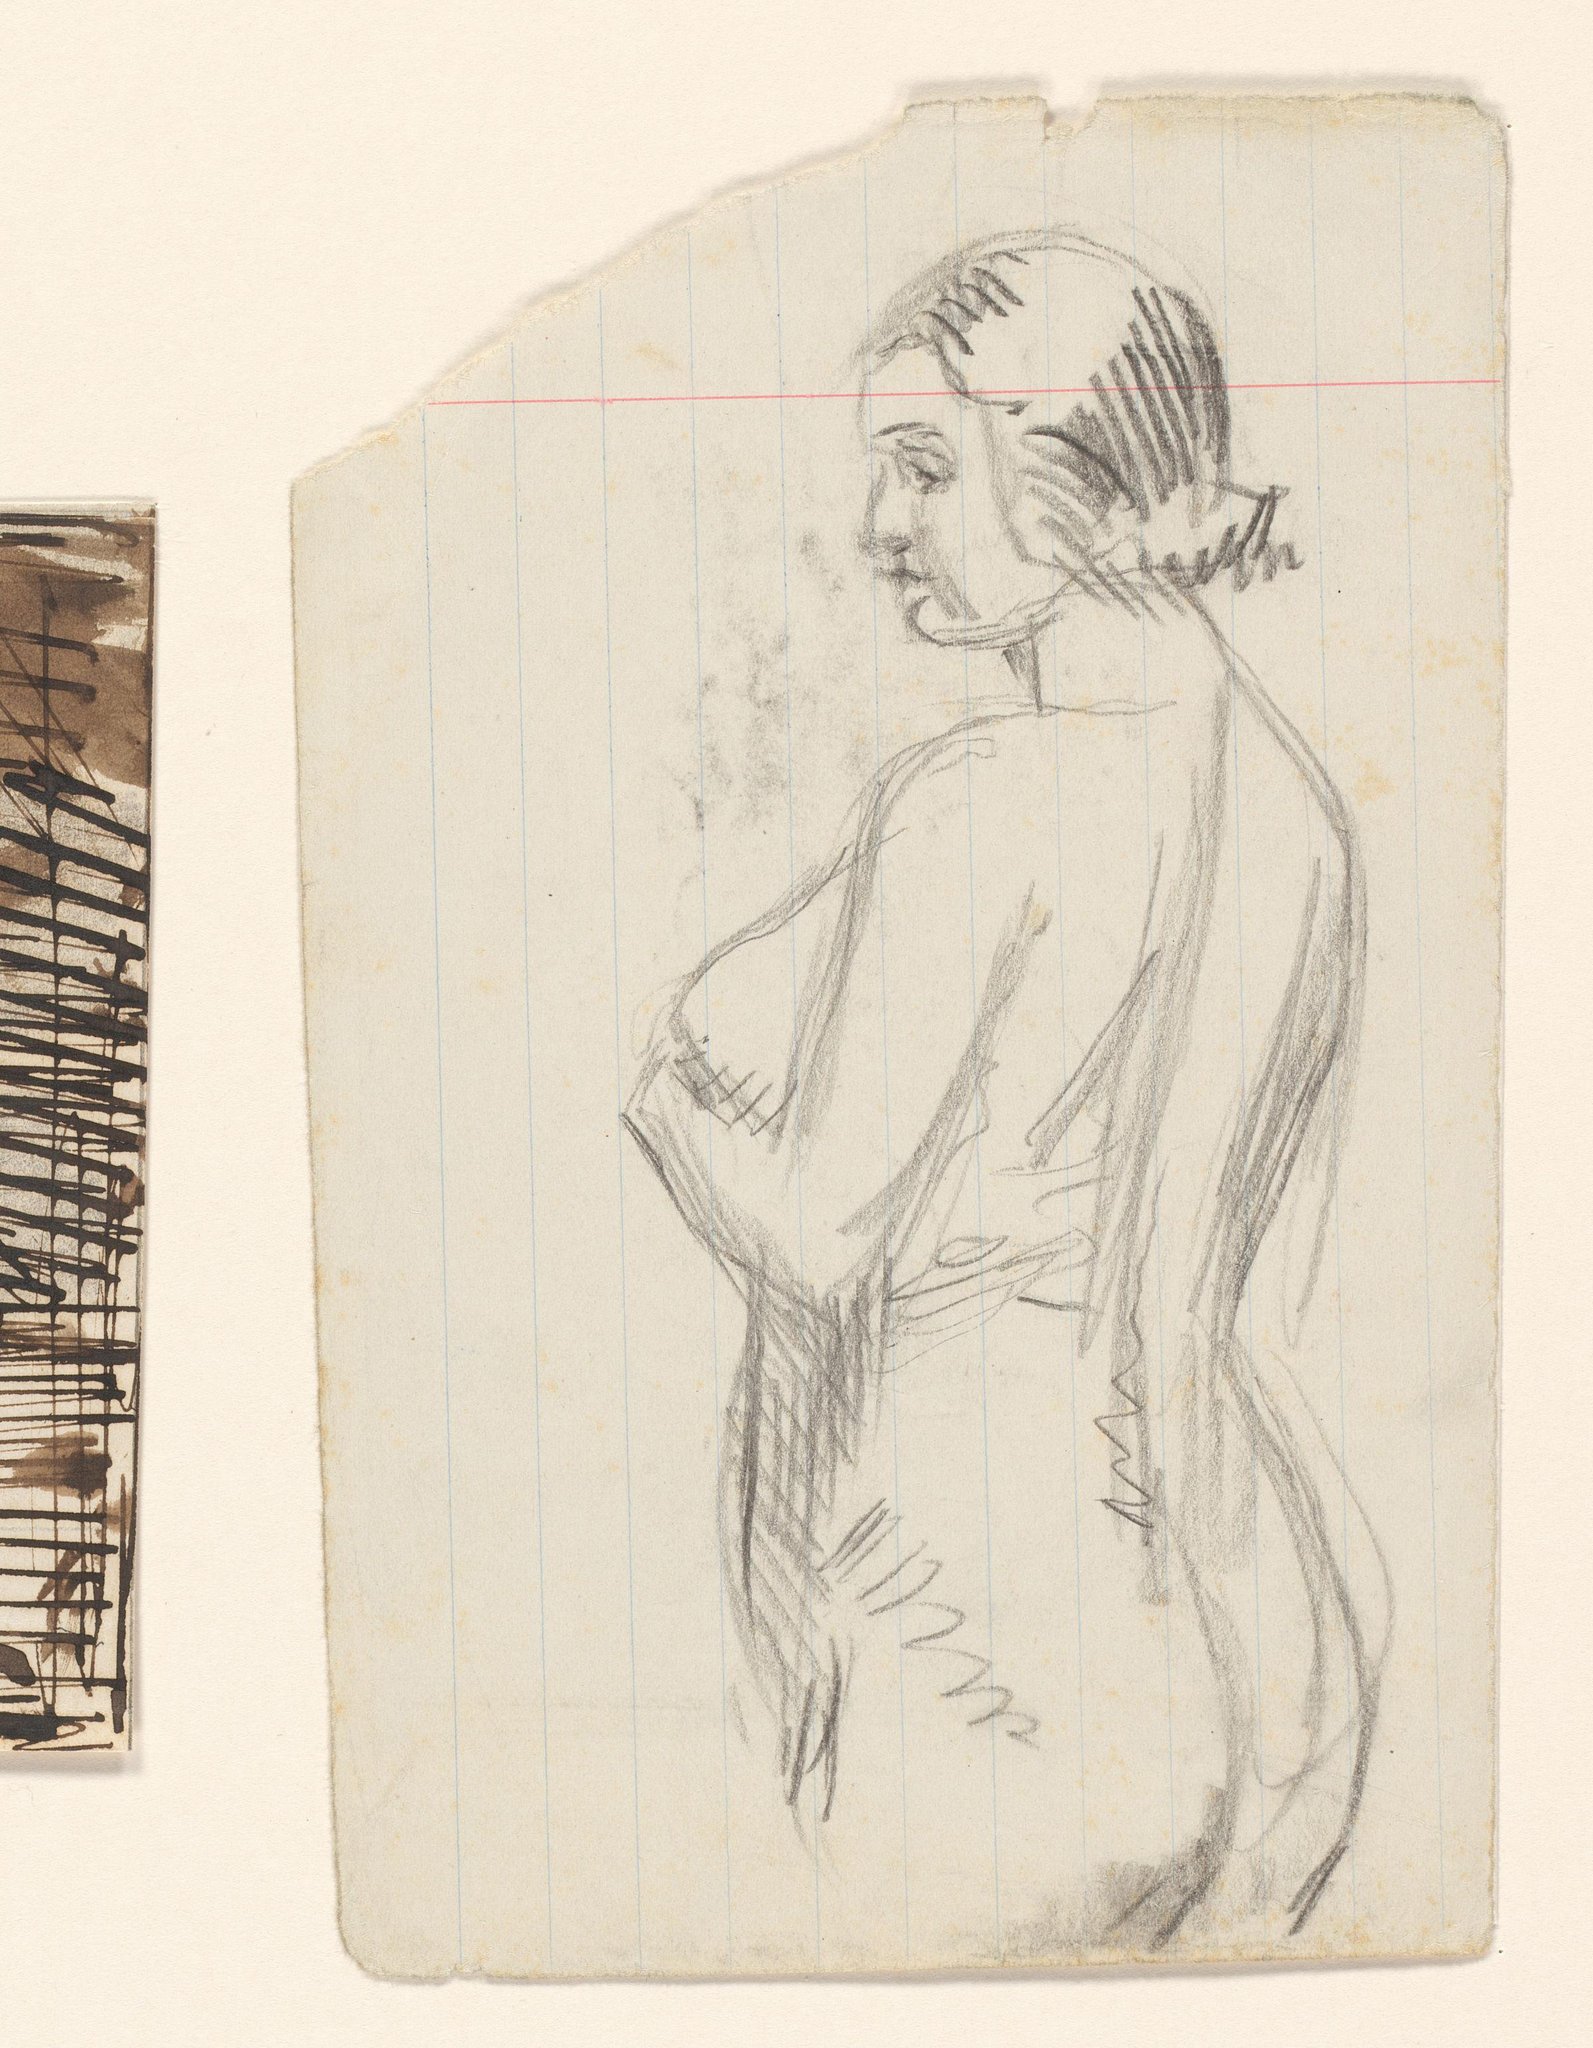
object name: drawing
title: Schetsblad met vrouwelijk naakt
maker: august allebé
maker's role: draughtsman, print maker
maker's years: 1838-1927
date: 1848-1927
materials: chalk, paper